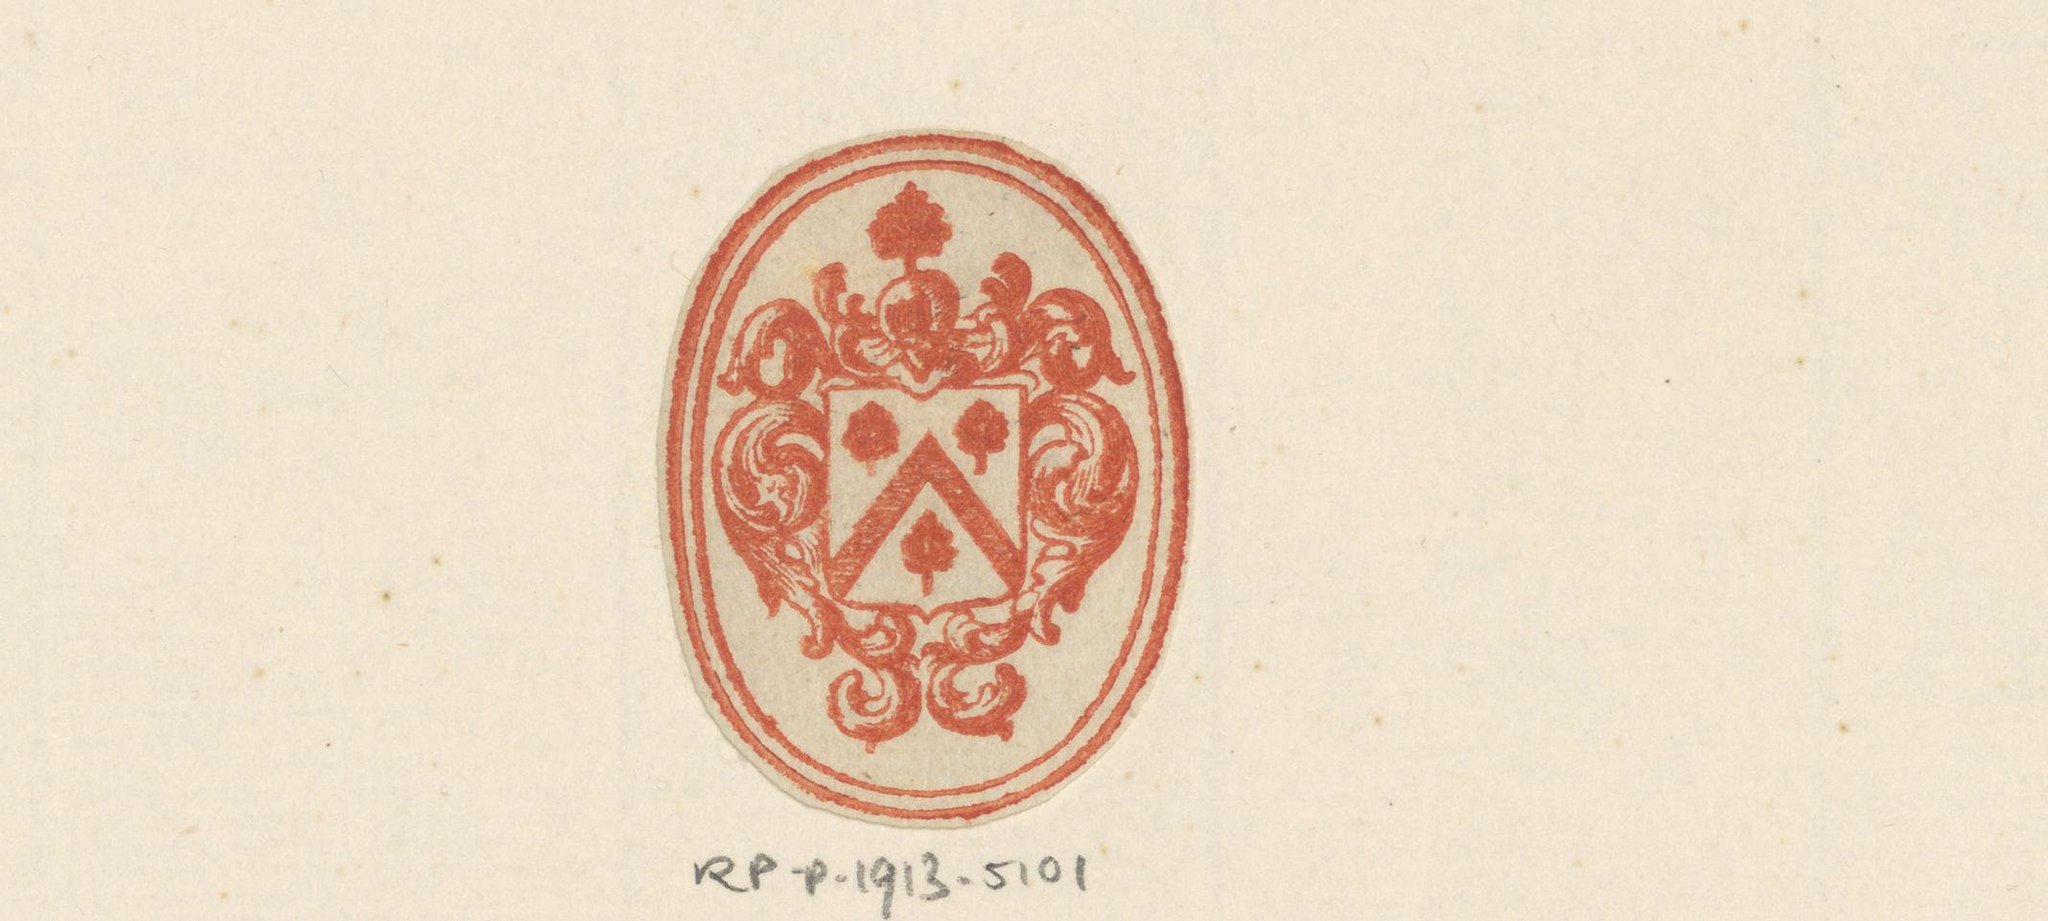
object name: bookplate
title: Ex libris van Van Walré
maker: Anonymous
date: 1750-1899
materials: paper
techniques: woodcut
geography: netherlands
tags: trees, armorial bearing, heraldry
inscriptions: collector's mark: Lugt 2233, collector's mark: Lugt 2760